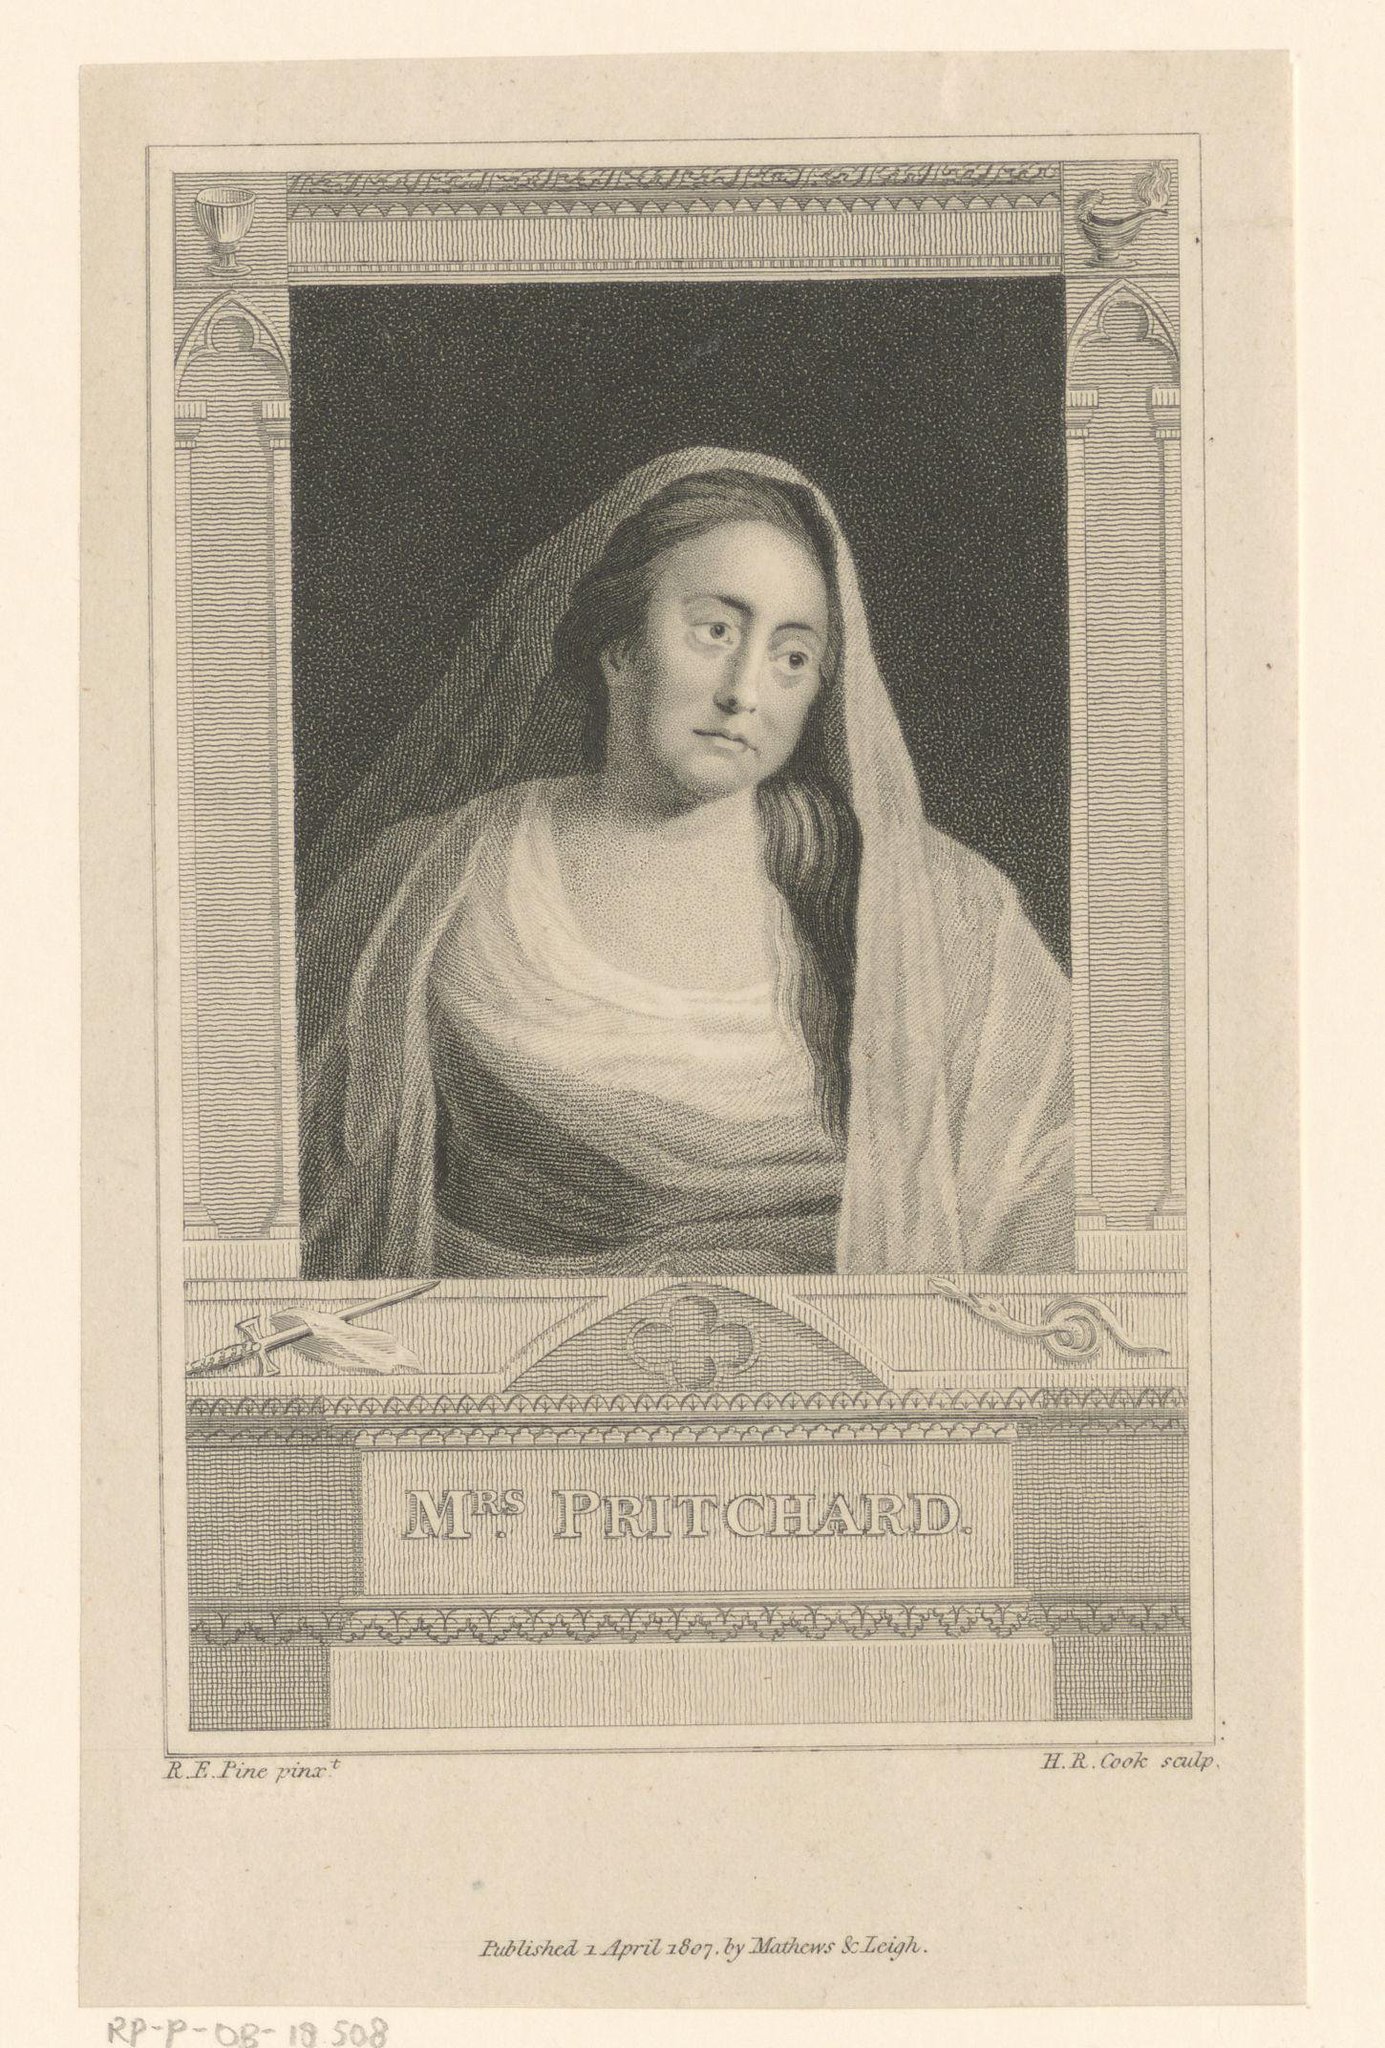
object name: print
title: Portret van Hannah Pritchard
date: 1807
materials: paper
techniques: etching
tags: historical persons, portrait of actor, actress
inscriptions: collector's mark: Lugt 2228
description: Gebruikt in: The Cabinet: Or, Monthly Report of Polite Literature (1807).